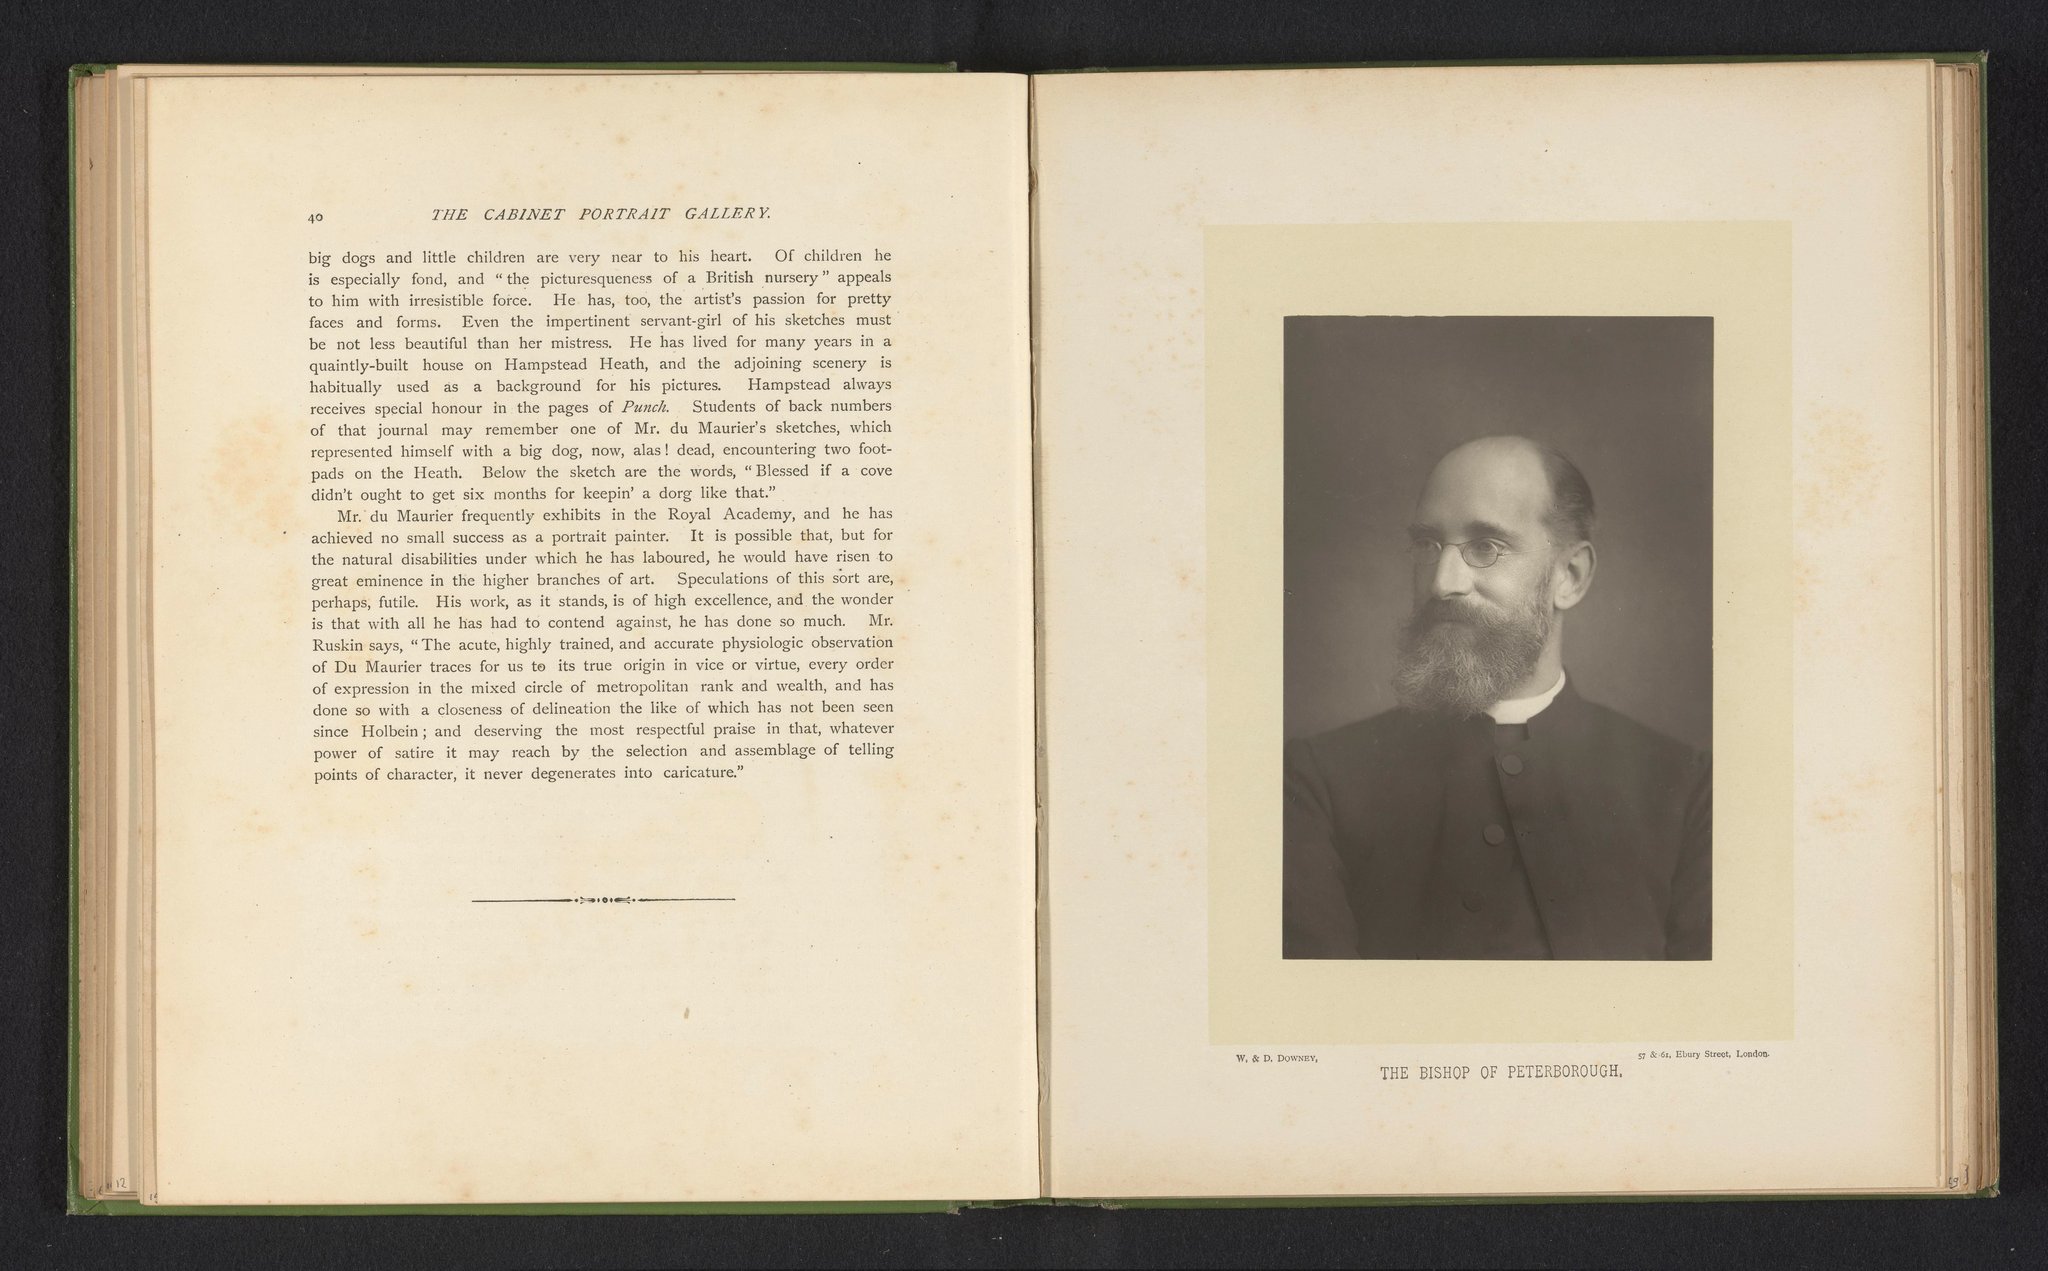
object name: page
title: The Bishop of Petersborough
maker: Anonymous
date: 1884-1894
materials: paper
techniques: woodburytype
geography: london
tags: archbishop, bishop, etc. (roman catholic)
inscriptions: inscription: ‘57 & 61, Elbury Street, London.’